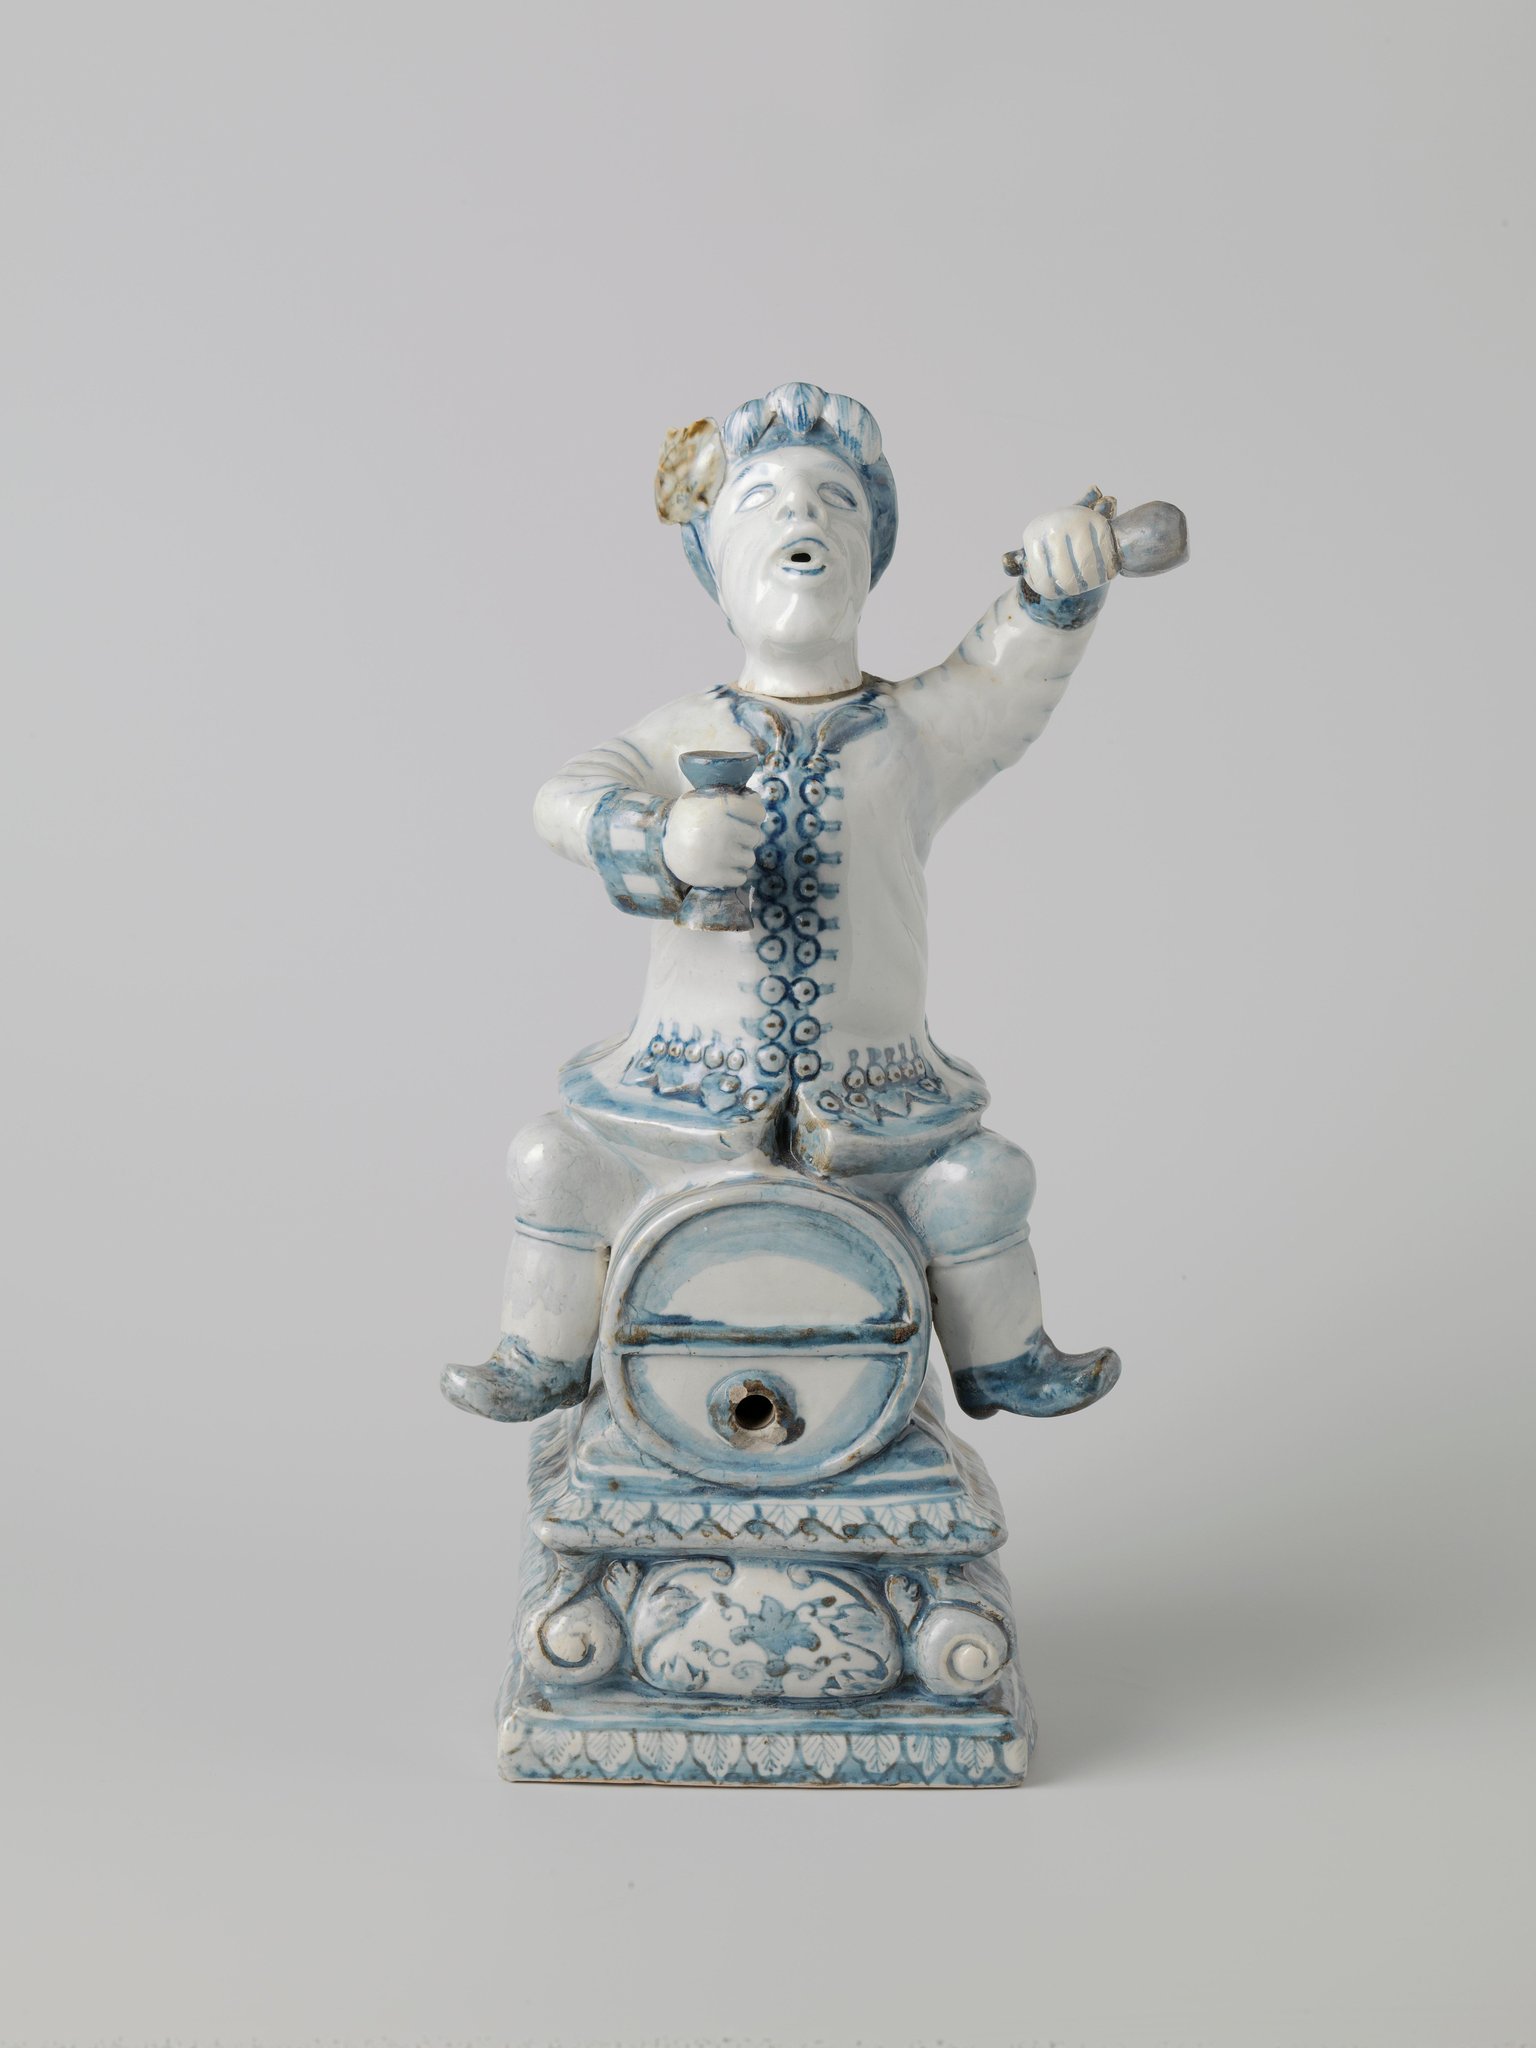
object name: ewer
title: Spirit keg in the shape of a Dutchman sitting astride a barrel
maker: Anonymous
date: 1750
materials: cobalt, glaze, paint, porcelain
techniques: firing, forming, vitrification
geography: japan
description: Kan van porselein. De kan heeft de vorm van een man zittende op een ton, blauw beschilderd. Uit de ton steekt een koperen kraantje.